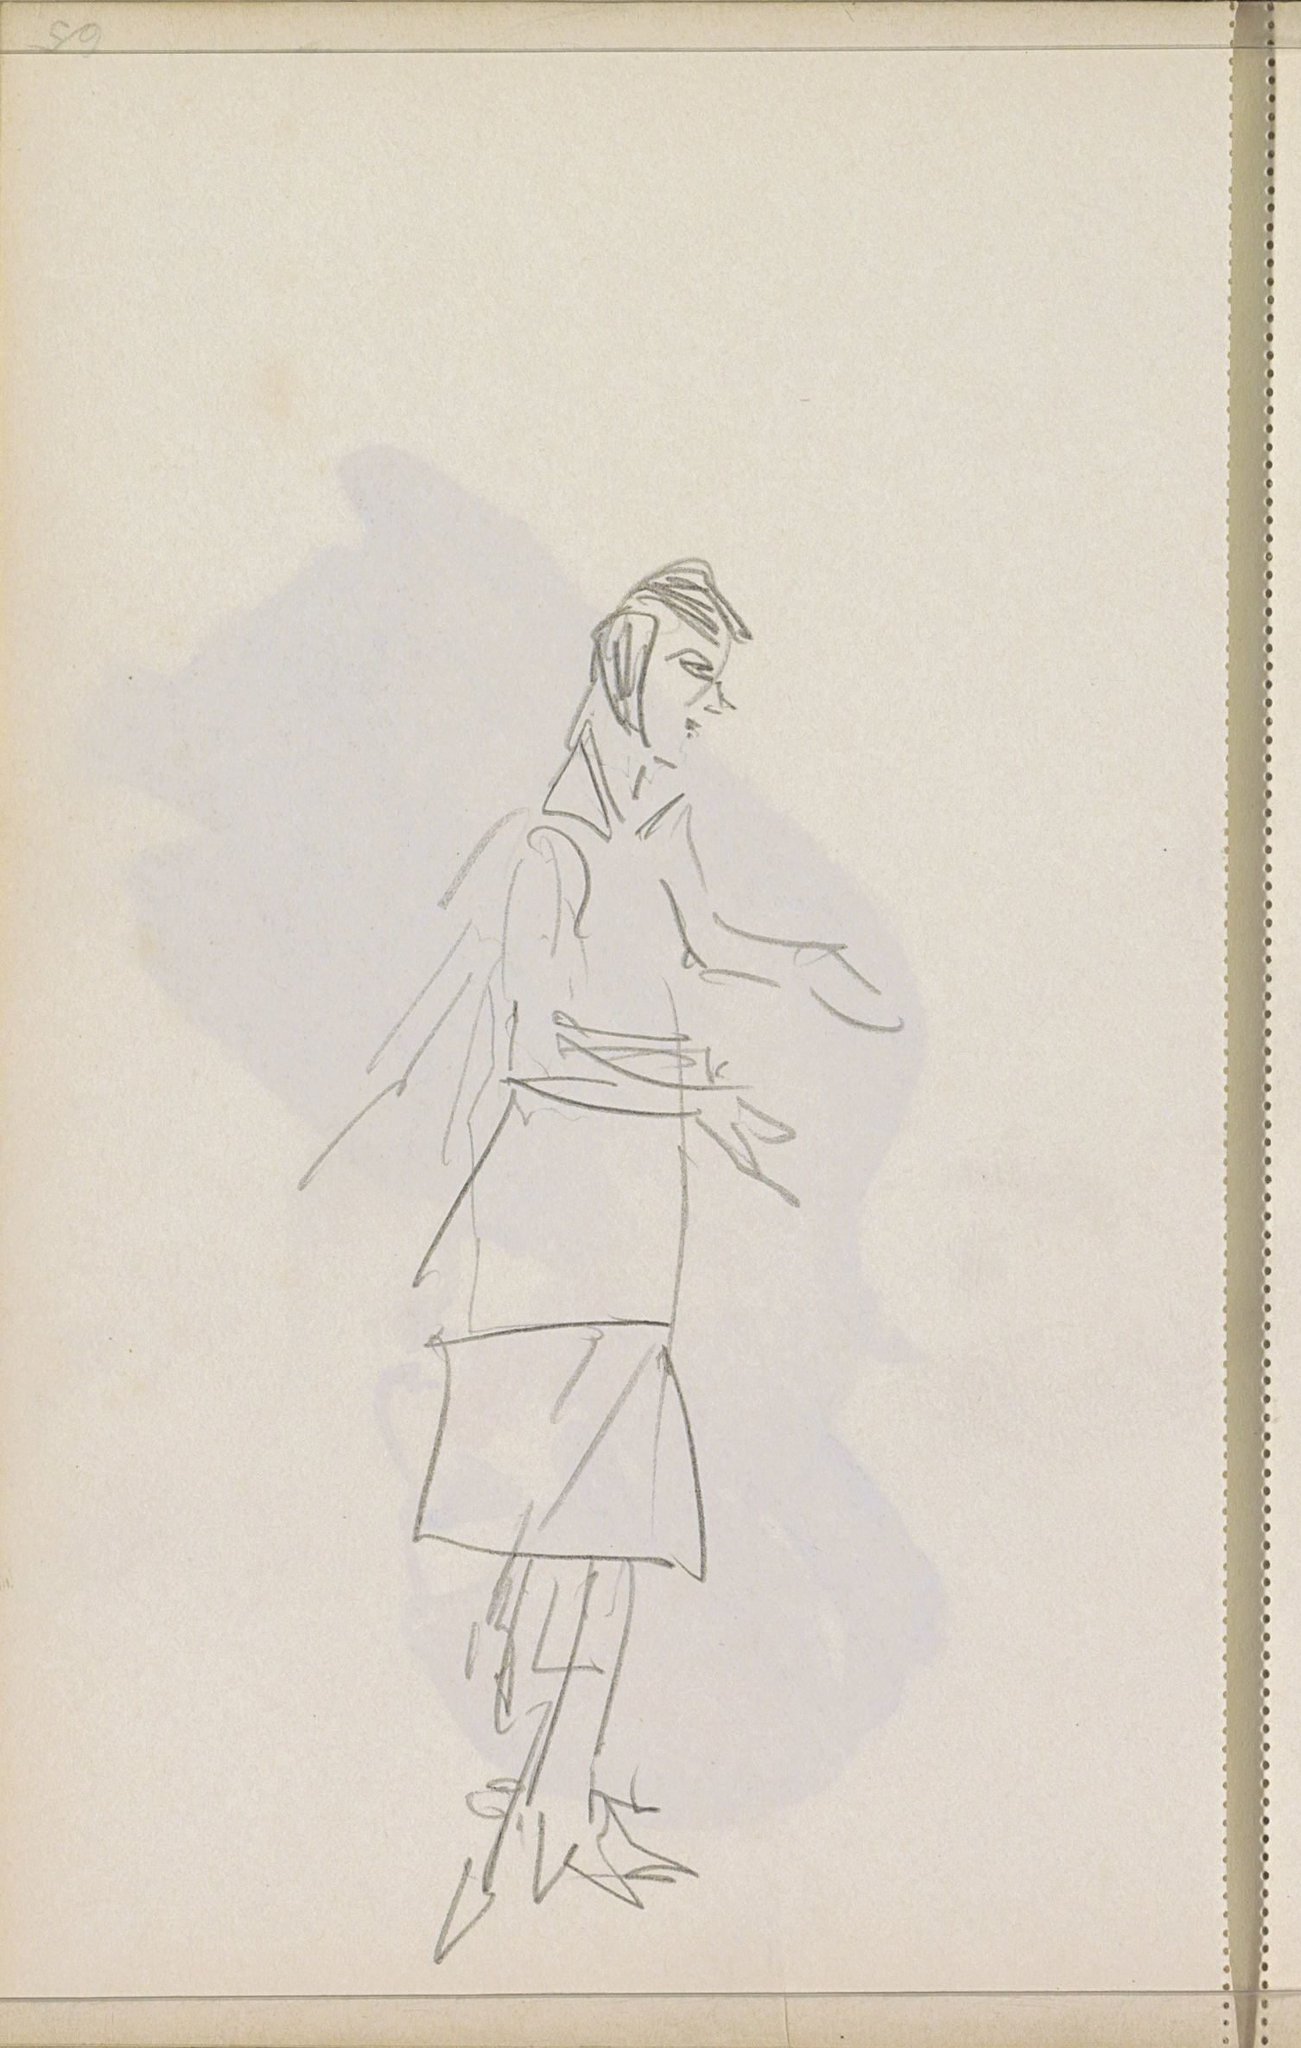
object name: sketchbook leaf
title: Staande vrouw met uitgestoken handen, in profiel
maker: isaac israels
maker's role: draughtsman, painter, print maker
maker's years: 1865-1934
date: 1875-1934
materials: paper, pencil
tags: arm stretched forward - aa - both arms or hands, adult woman (+ standing)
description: Blad 22 verso uit schetsboek LII met 43 bladen.